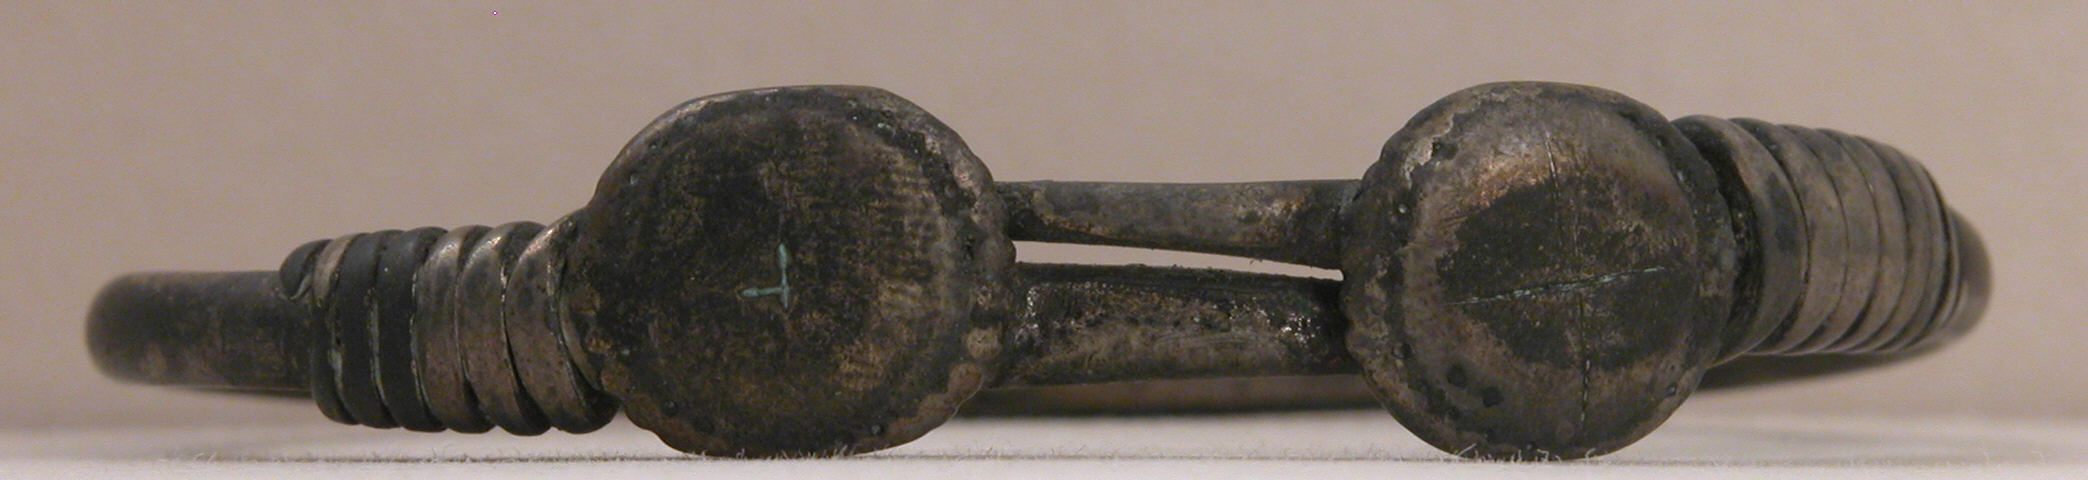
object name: bracelet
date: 401-800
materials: silver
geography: palestine